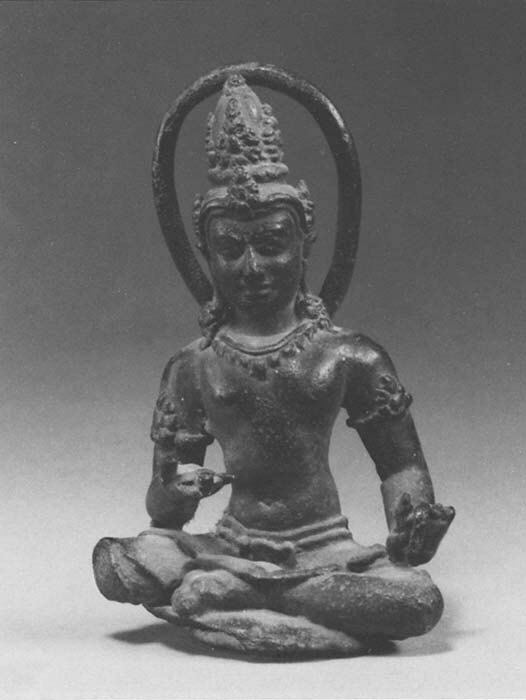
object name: figurine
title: Seated Bodhisattva Vajrapani (?)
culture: indonesian, javanese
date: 834-866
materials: bronze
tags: buddhism,bodhisattvas,vajrapani